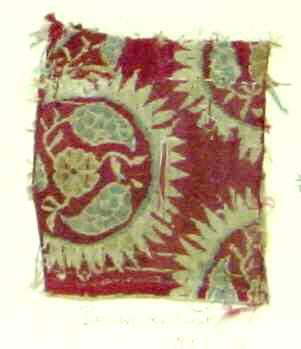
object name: textile fragment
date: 1501-1600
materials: silk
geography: turkey